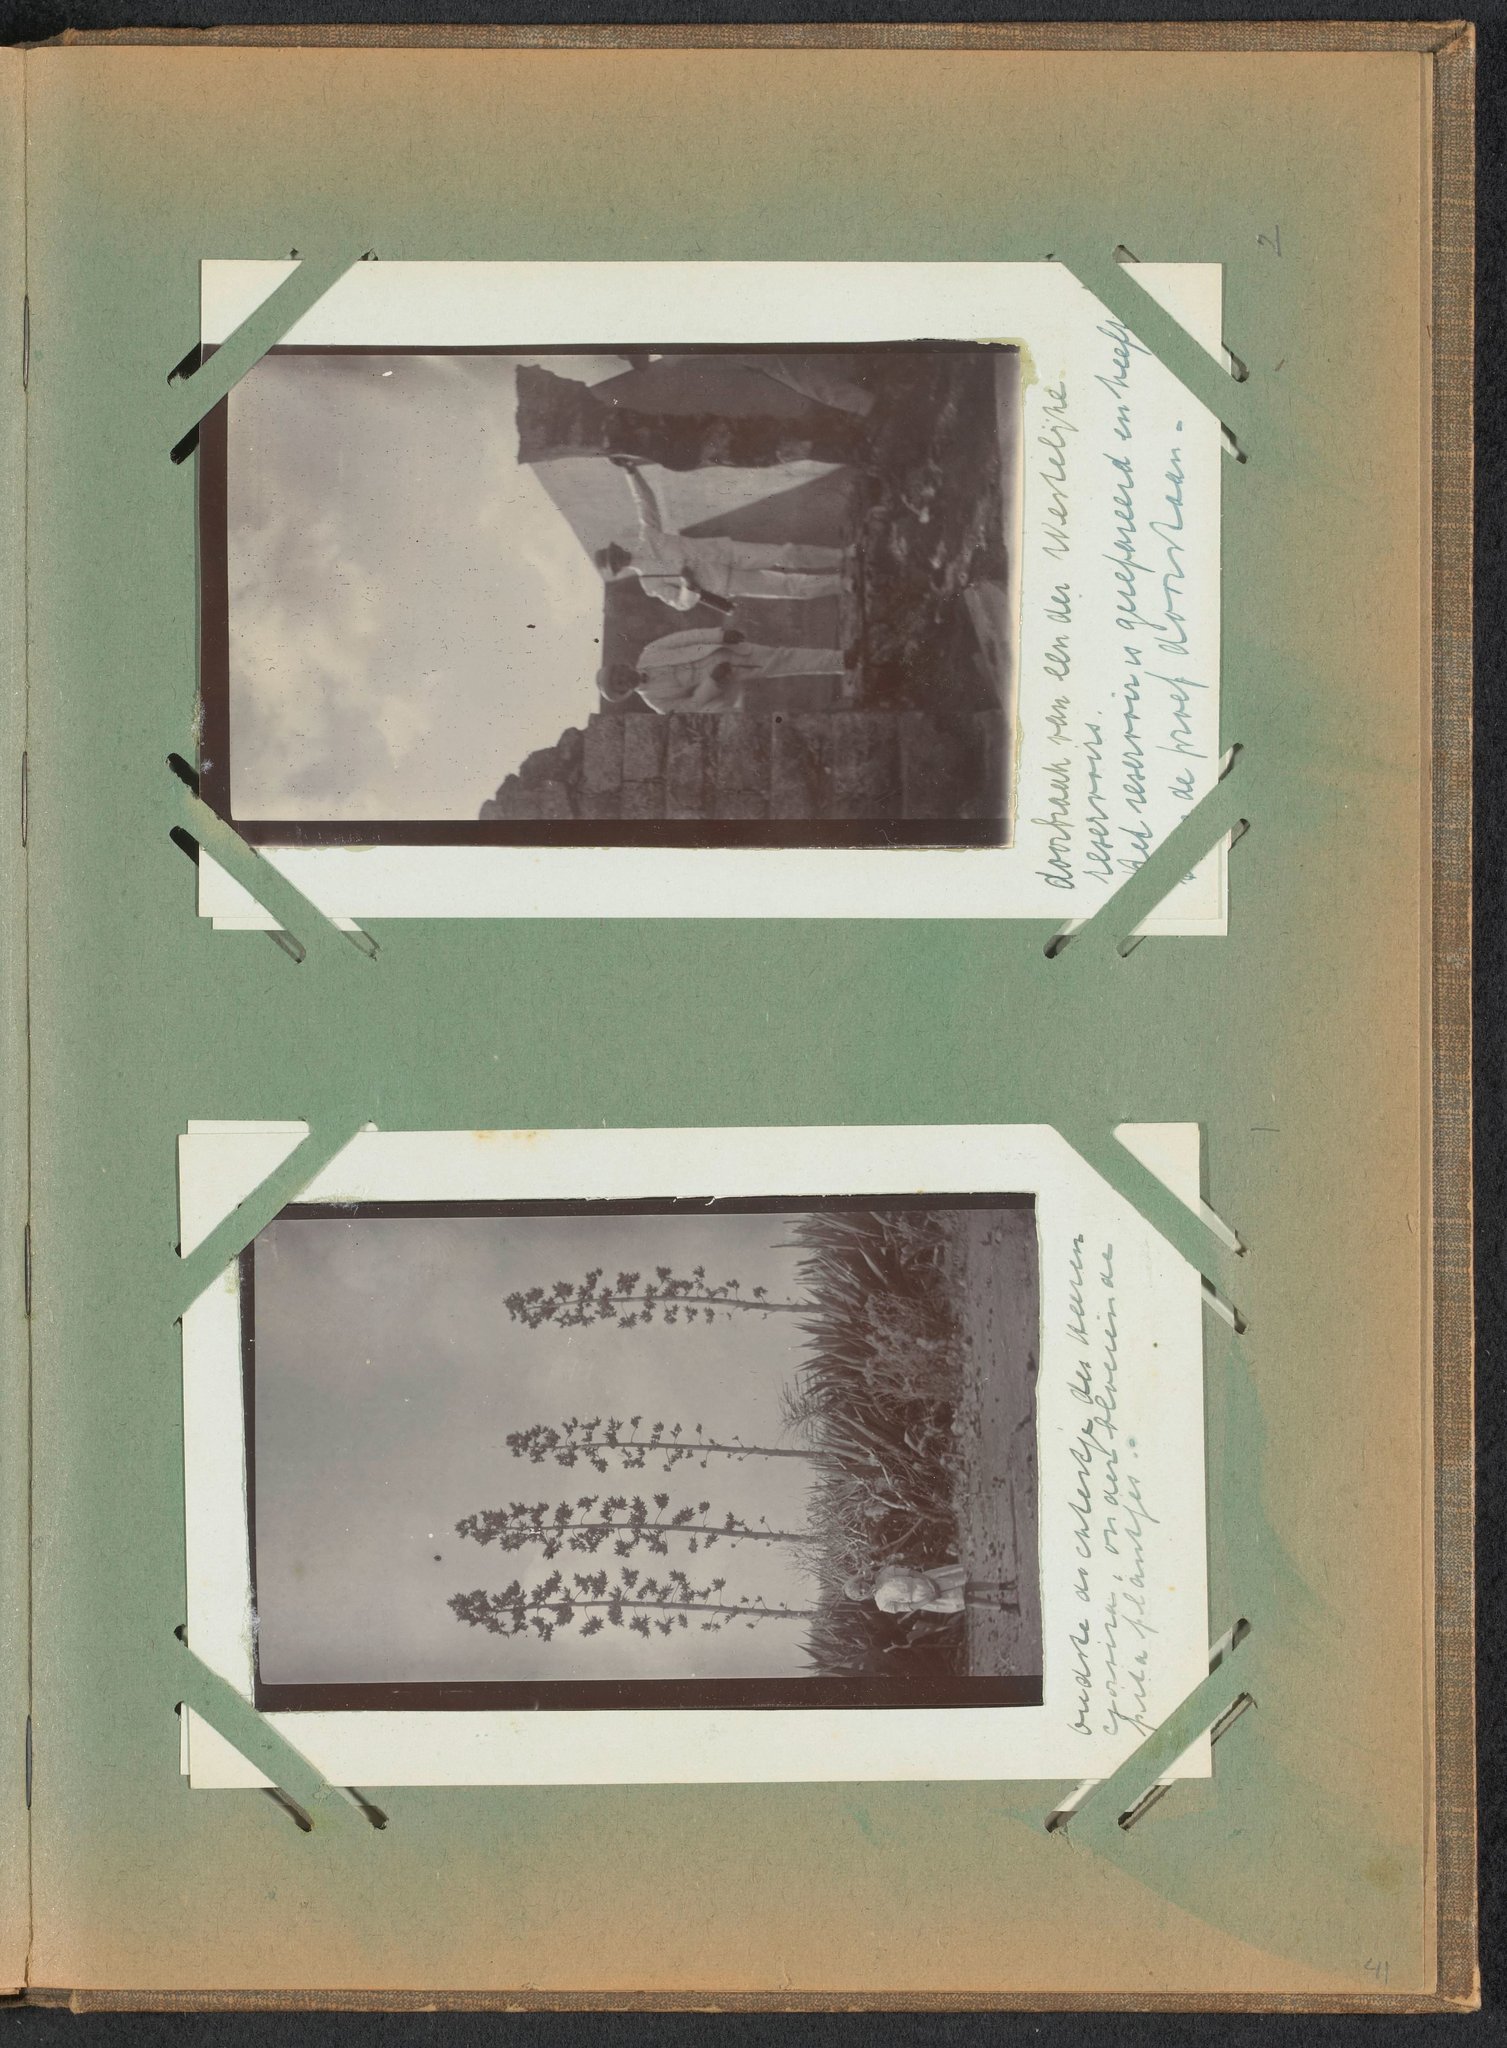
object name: photograph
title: doorbraak van een der Westelijke reservoirs (...)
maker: Anonymous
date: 1912-1913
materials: paper, photographic support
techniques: gelatin silver print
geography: curacao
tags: plantation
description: Twee mannen staande in een doorgebroken reservoir bij Plantage Mount Pleasant op Curaçao. Onderdeel van het fotoalbum uit ca. 1912-1913 met 92 foto's van de plantages Peperpot en Dordrecht in Suriname en Mount Pleasant op Curaçao.